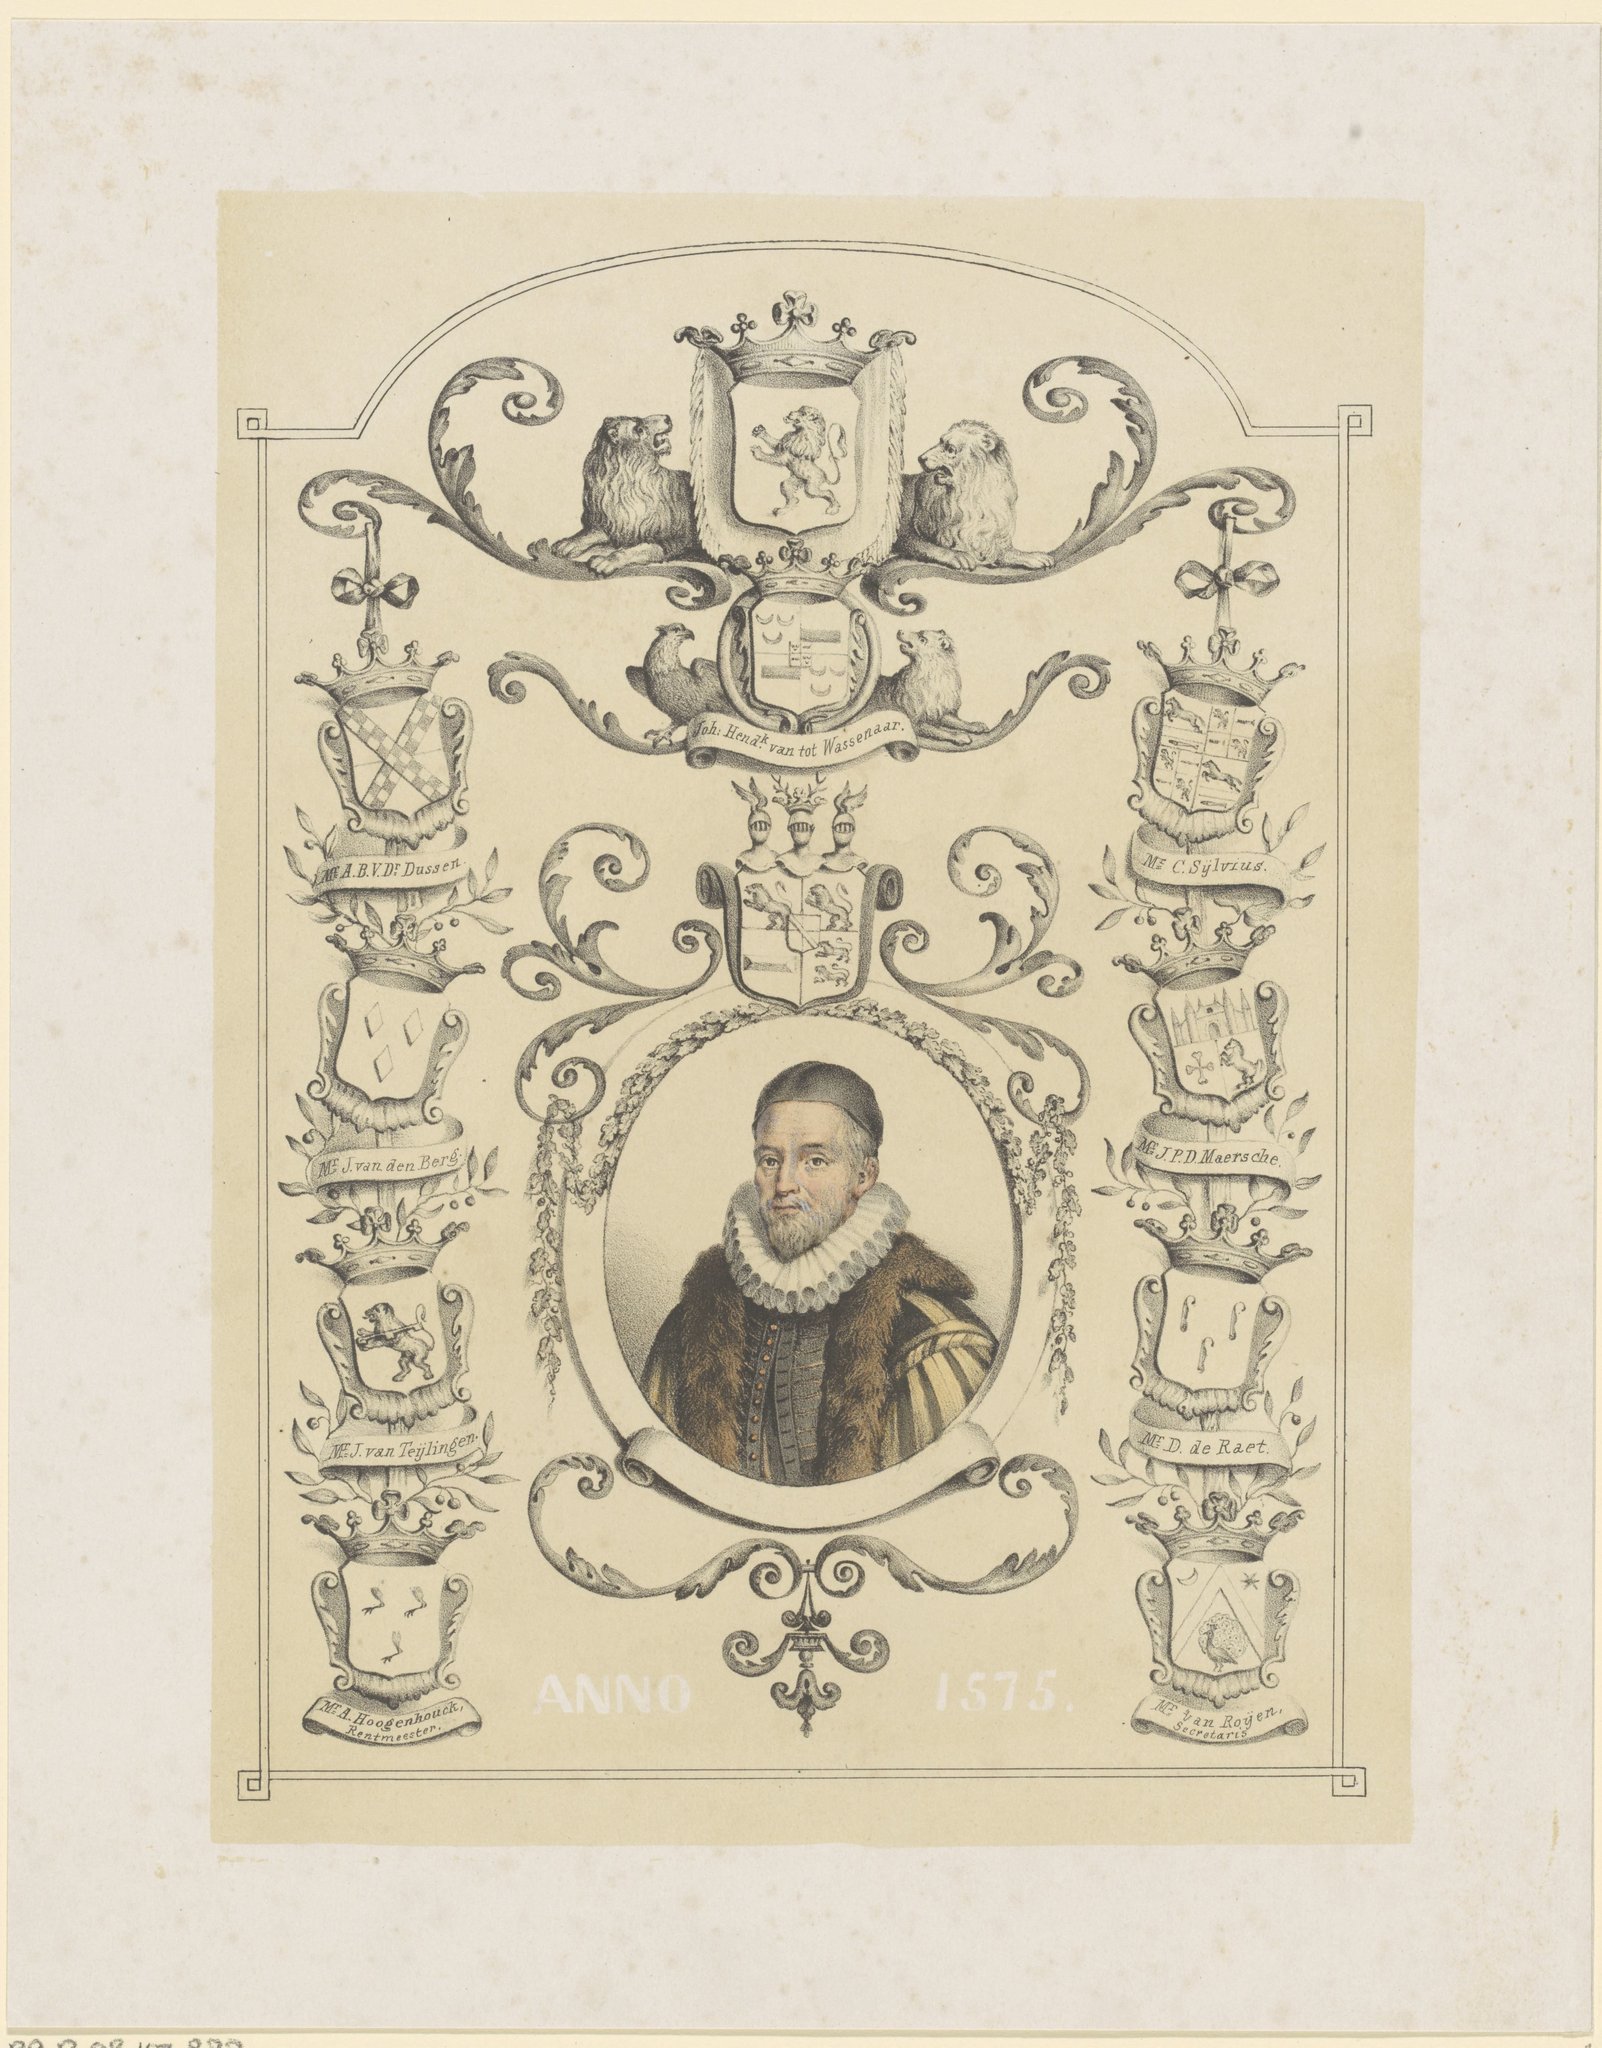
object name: print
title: Portret van Willem I, prins van Oranje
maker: leendert springer (i)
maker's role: draughtsman, painter, print maker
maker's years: 1789-1871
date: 1804-1853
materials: paper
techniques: lithograph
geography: leiden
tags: william i (prince of orange)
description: De hier vermelde titel verwijst naar de hoogst verkregen titel van de geportretteerde, niet per se naar de titel die de geportretteerde op deze voorstelling draagt.